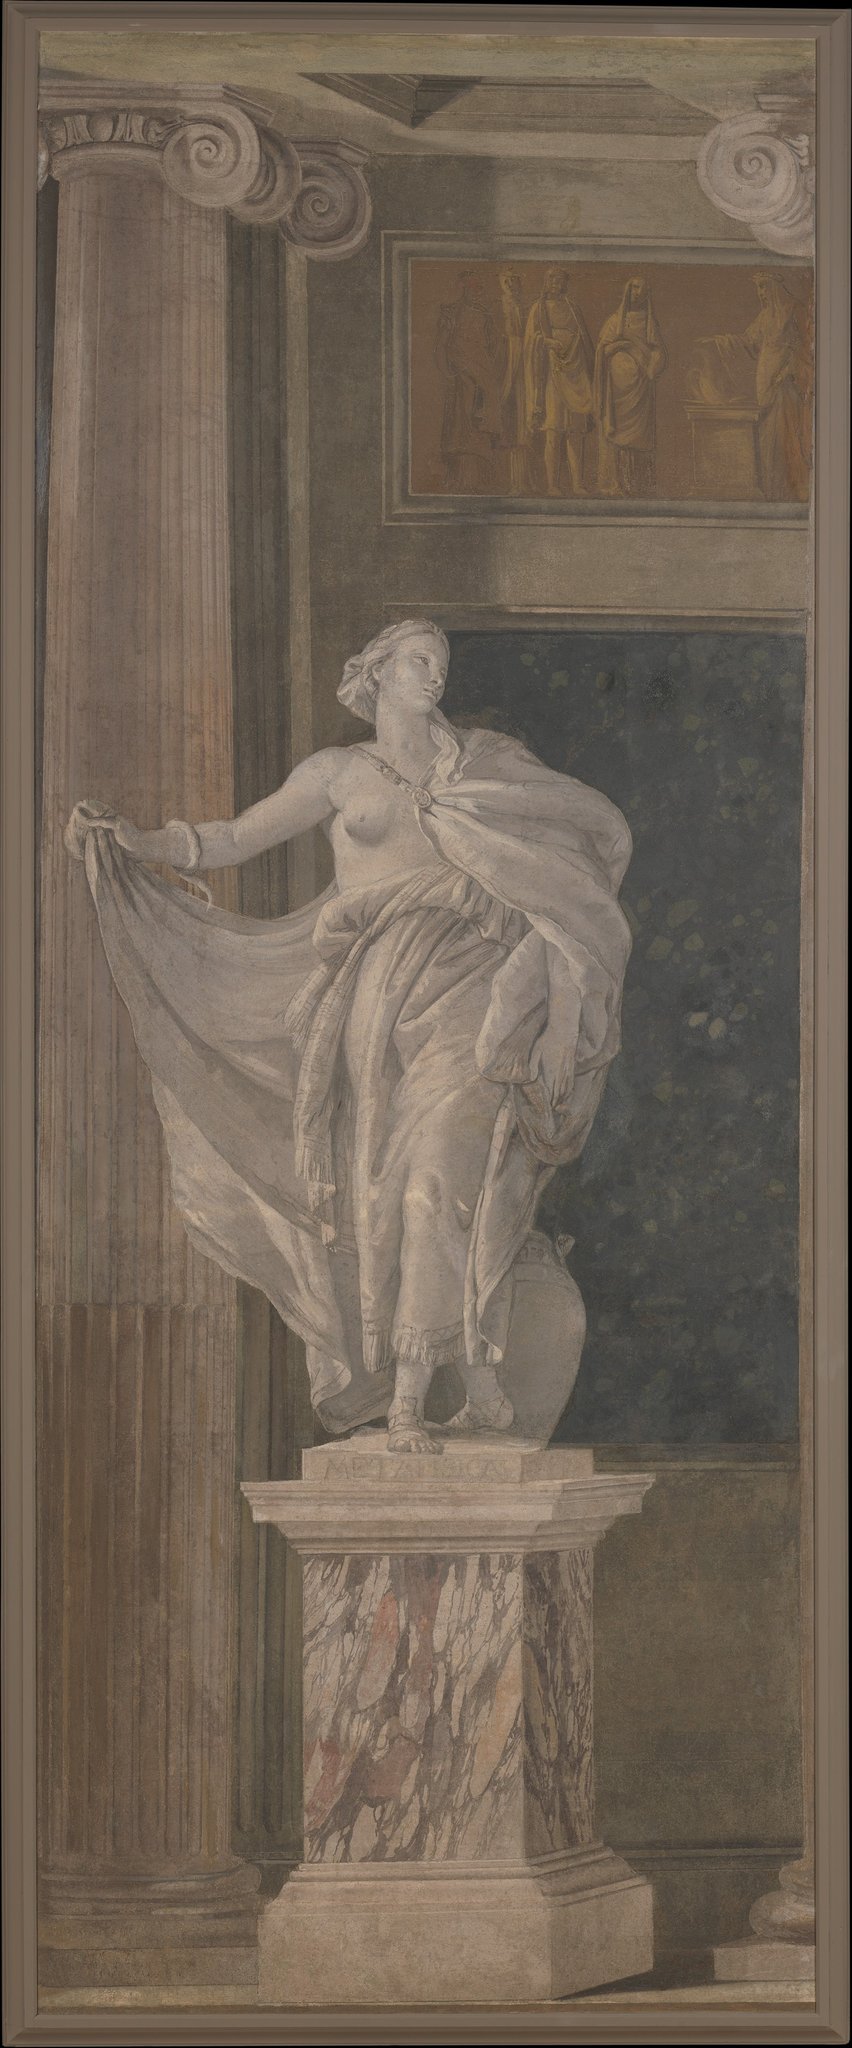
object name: painting, monochrome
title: Allegorical Figure Representing Metaphysics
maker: giovanni battista tiepolo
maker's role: artist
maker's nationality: italian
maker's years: 1696-1770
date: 1760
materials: canvas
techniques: fresco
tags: sculpture,female nudes,allegory